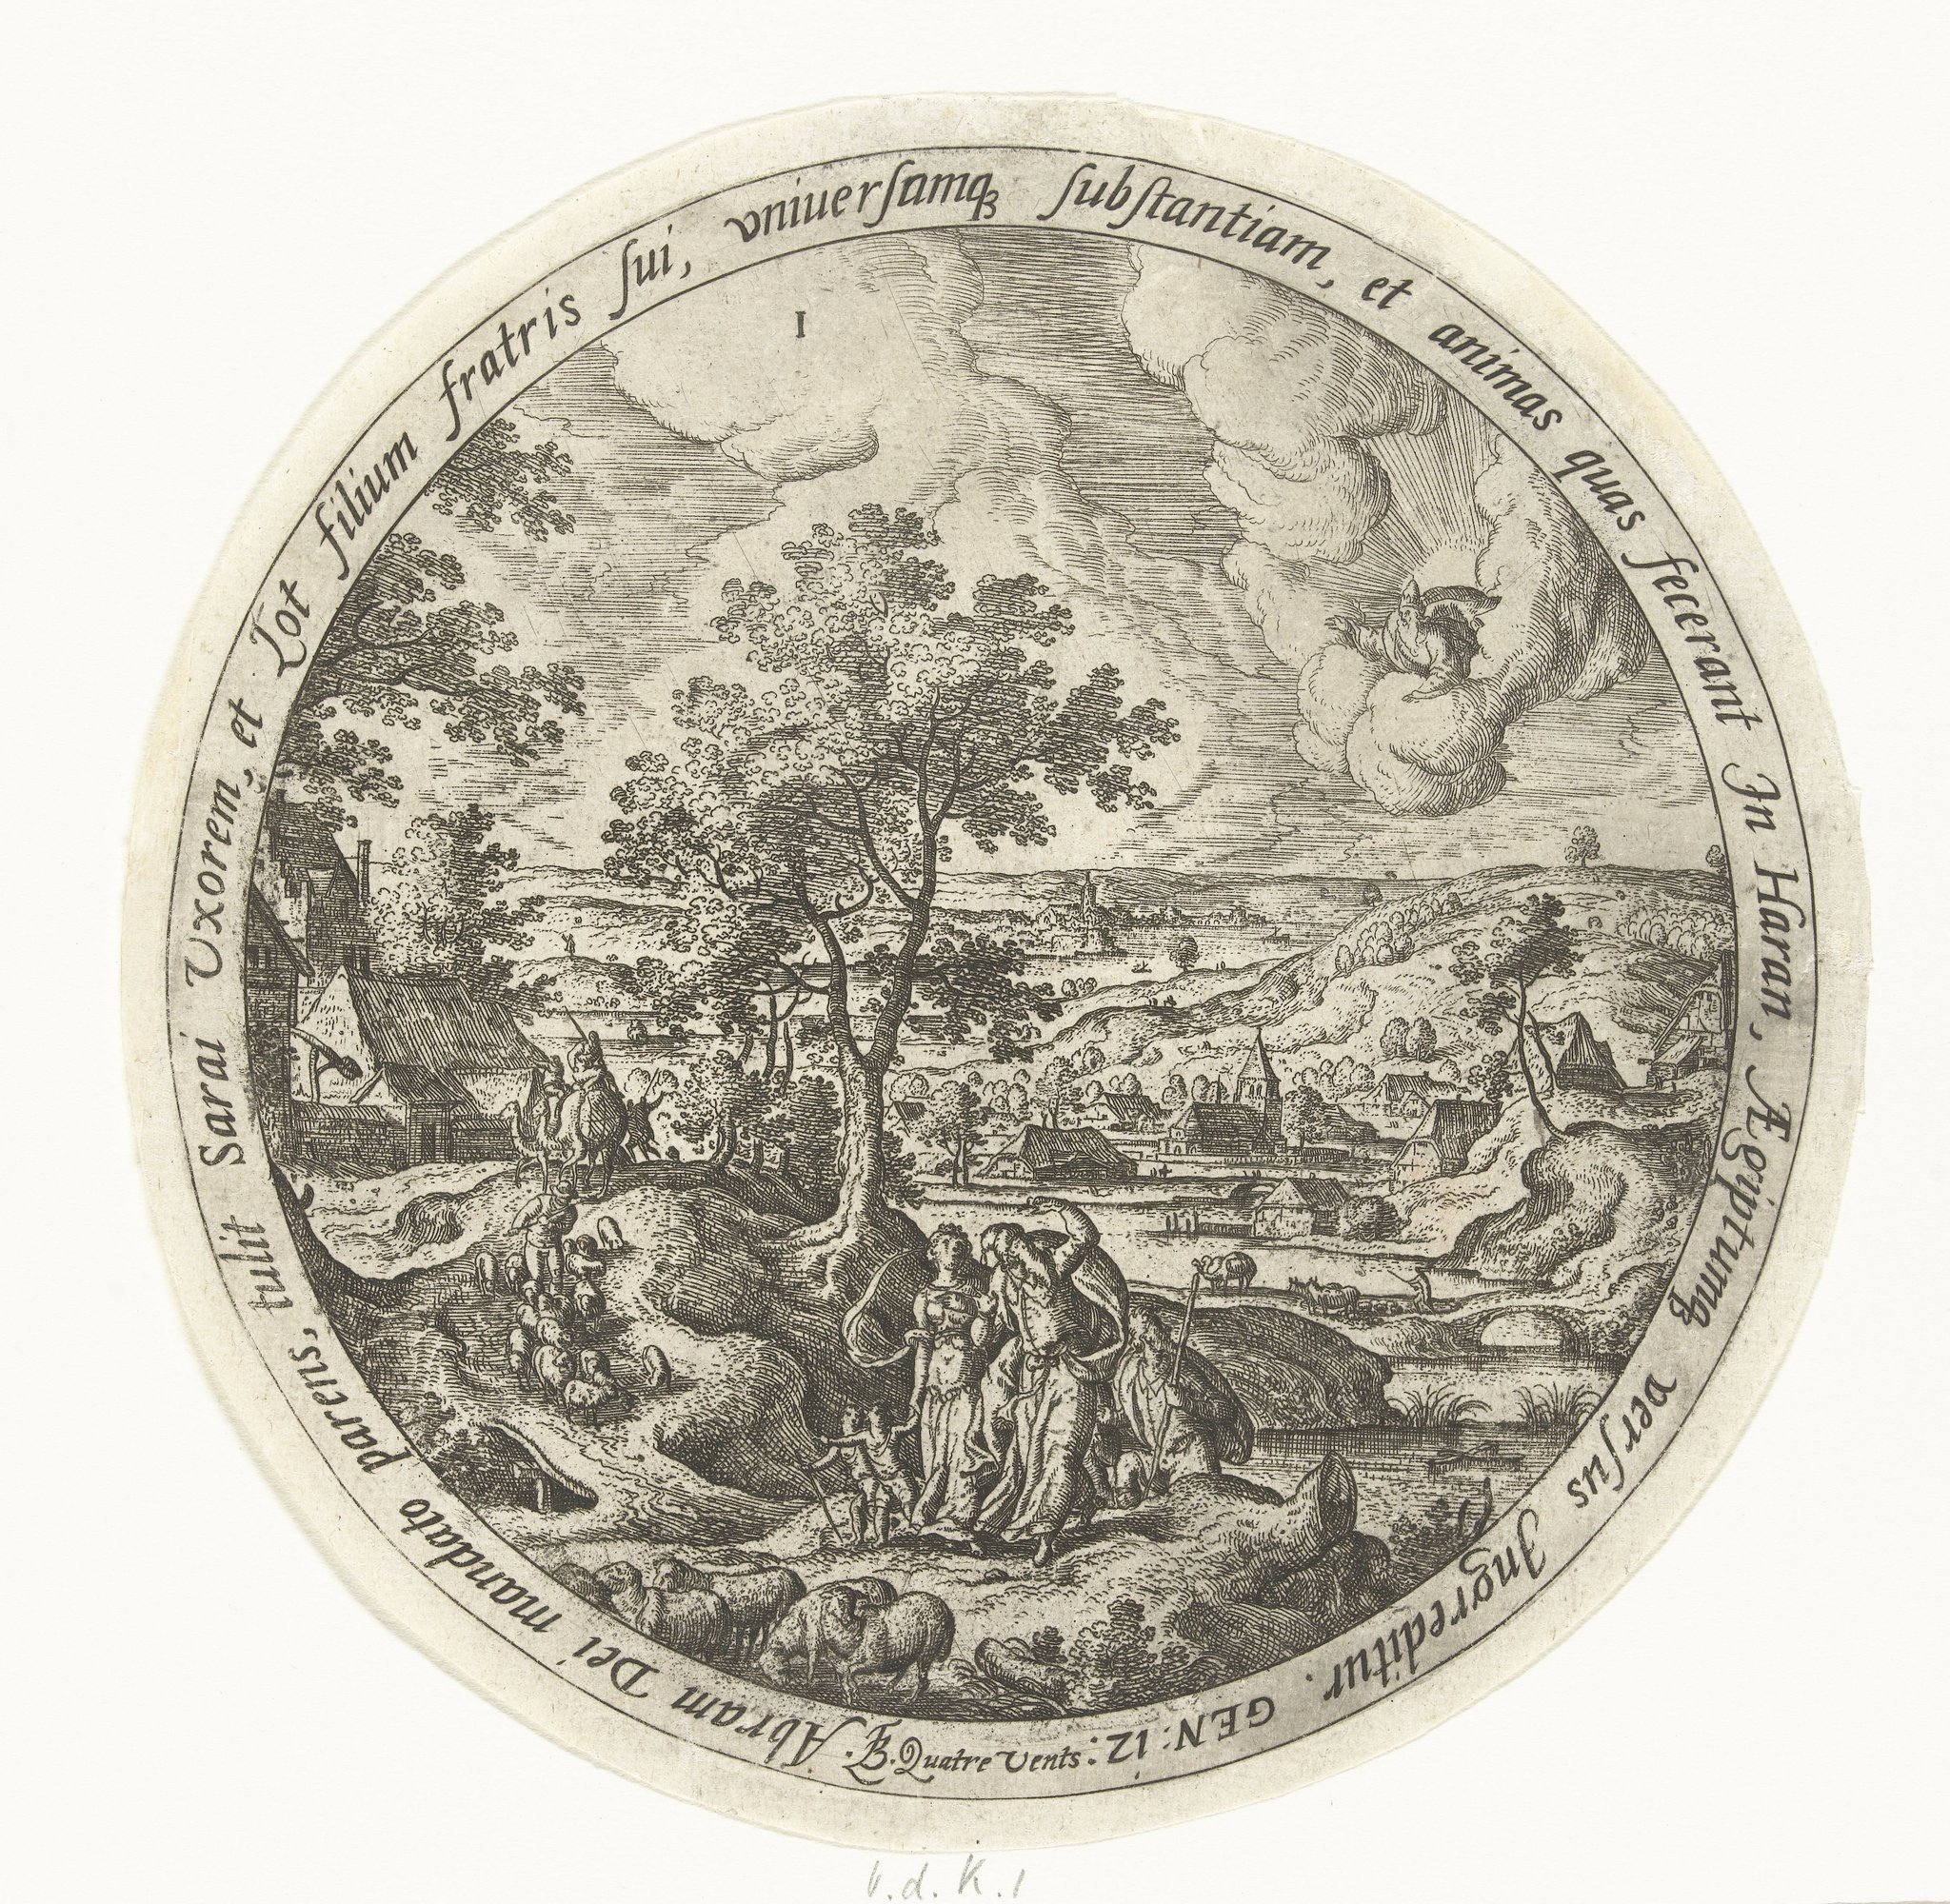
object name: print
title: Abraham op weg naar Kanaän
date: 1560-1570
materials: paper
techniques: etching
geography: antwerp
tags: abraham starts out for the land of canaan with sarah, lot and his belongings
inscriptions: collector's mark: Lugt 2228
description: Abraham trekt met zijn vrouw Sara en met zijn familie naar Kanaän. God, zwevend in een wolk, wijst hen de goede weg. Het groepje wandelt in een glooiend landschap met af en toe een boerderij of een dorp. Prent uit een serie van zes prenten die het levensverhaal van de aartsvader Abraham verbeelden.